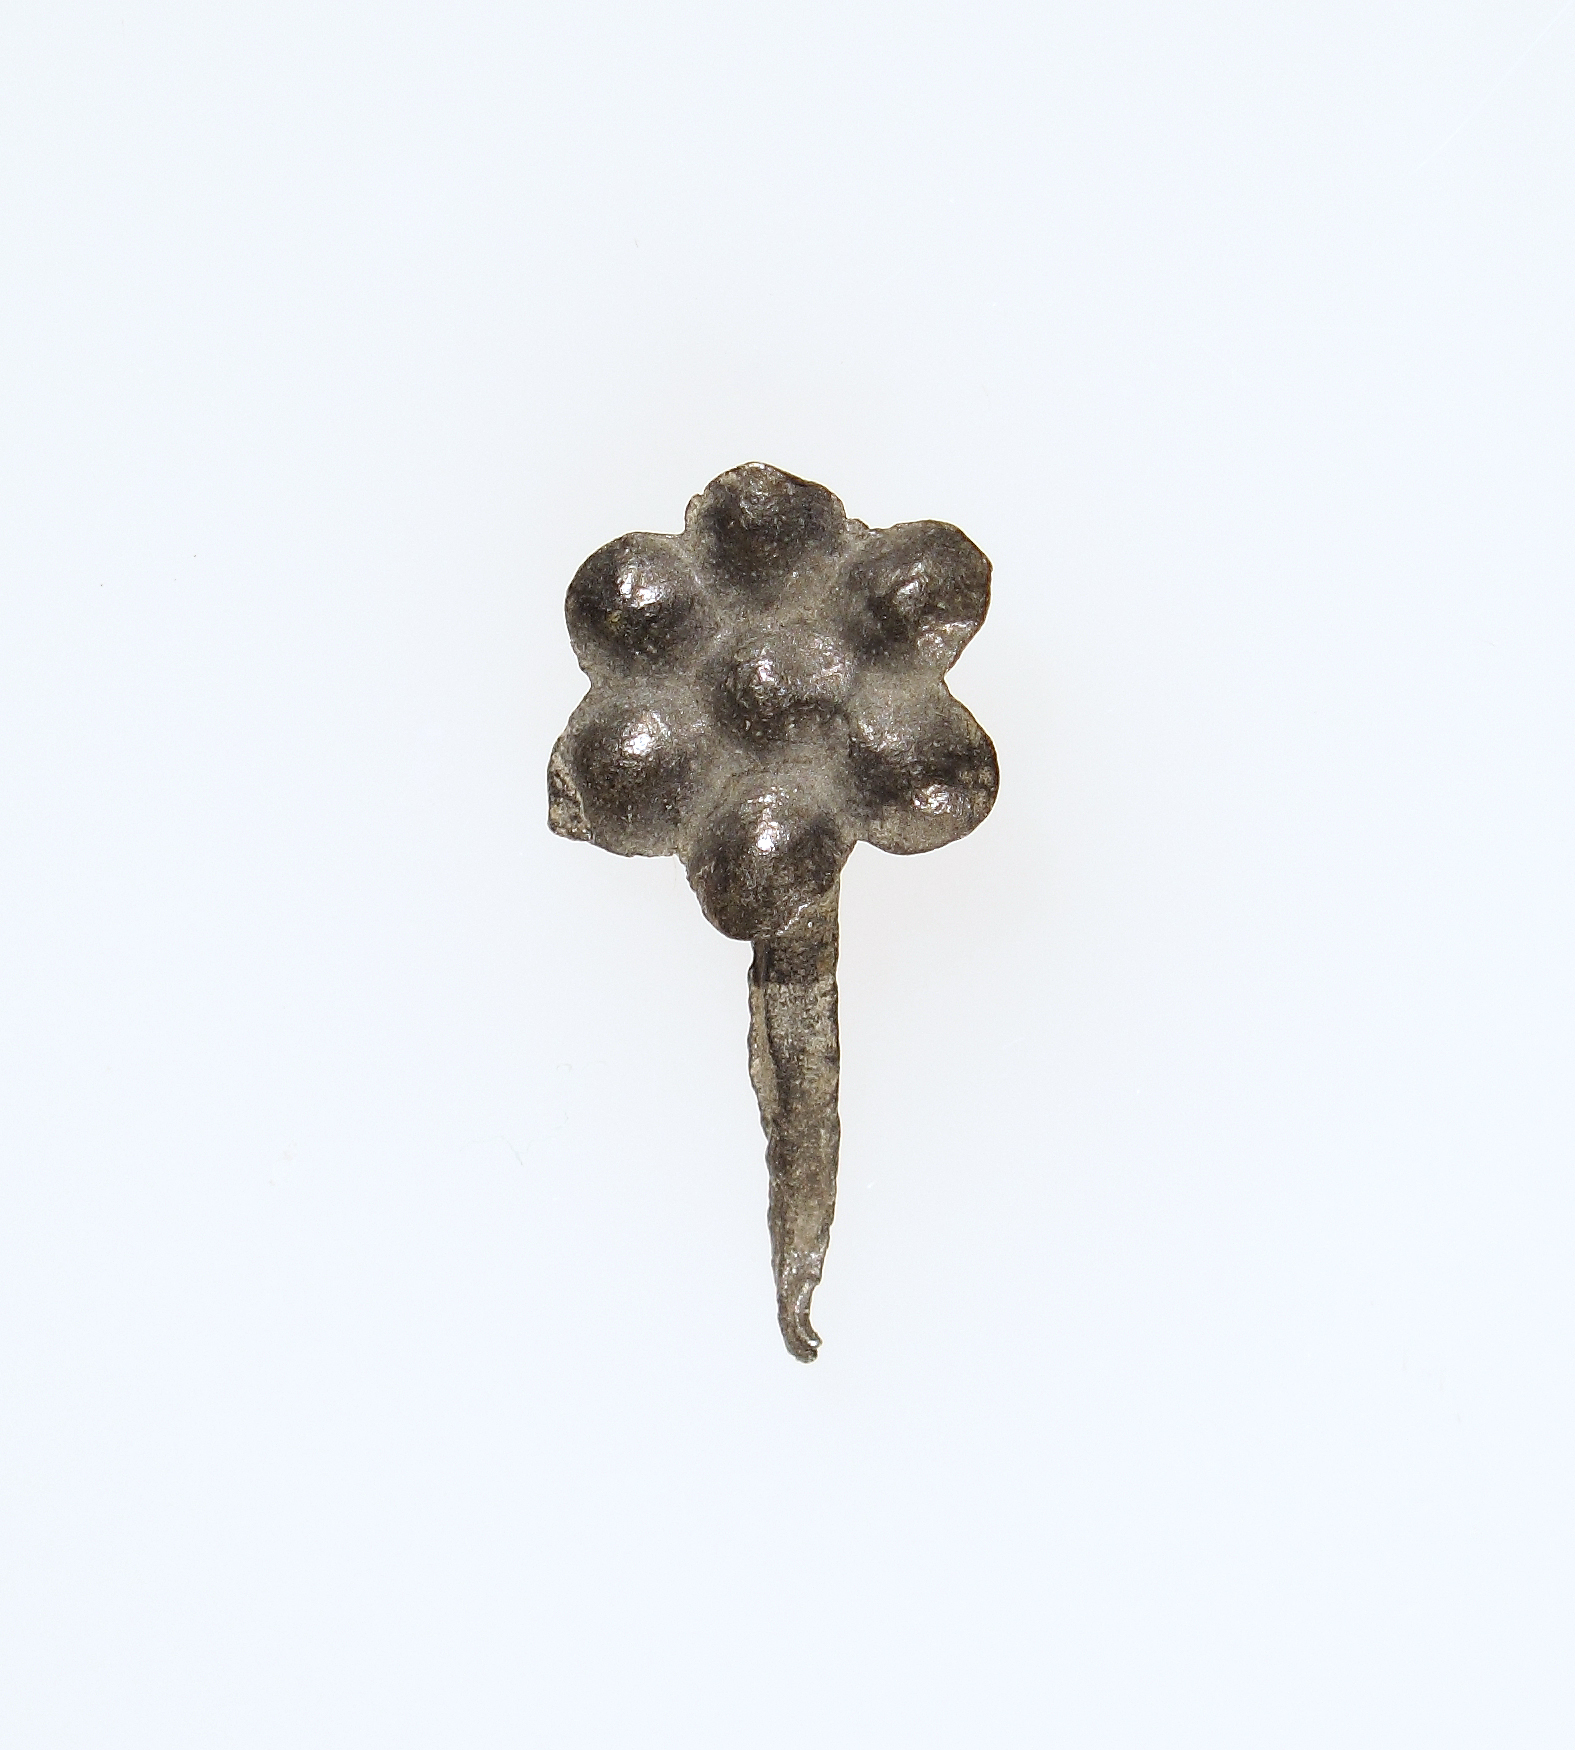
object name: pilgrim's badge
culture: french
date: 1401-1500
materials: lead